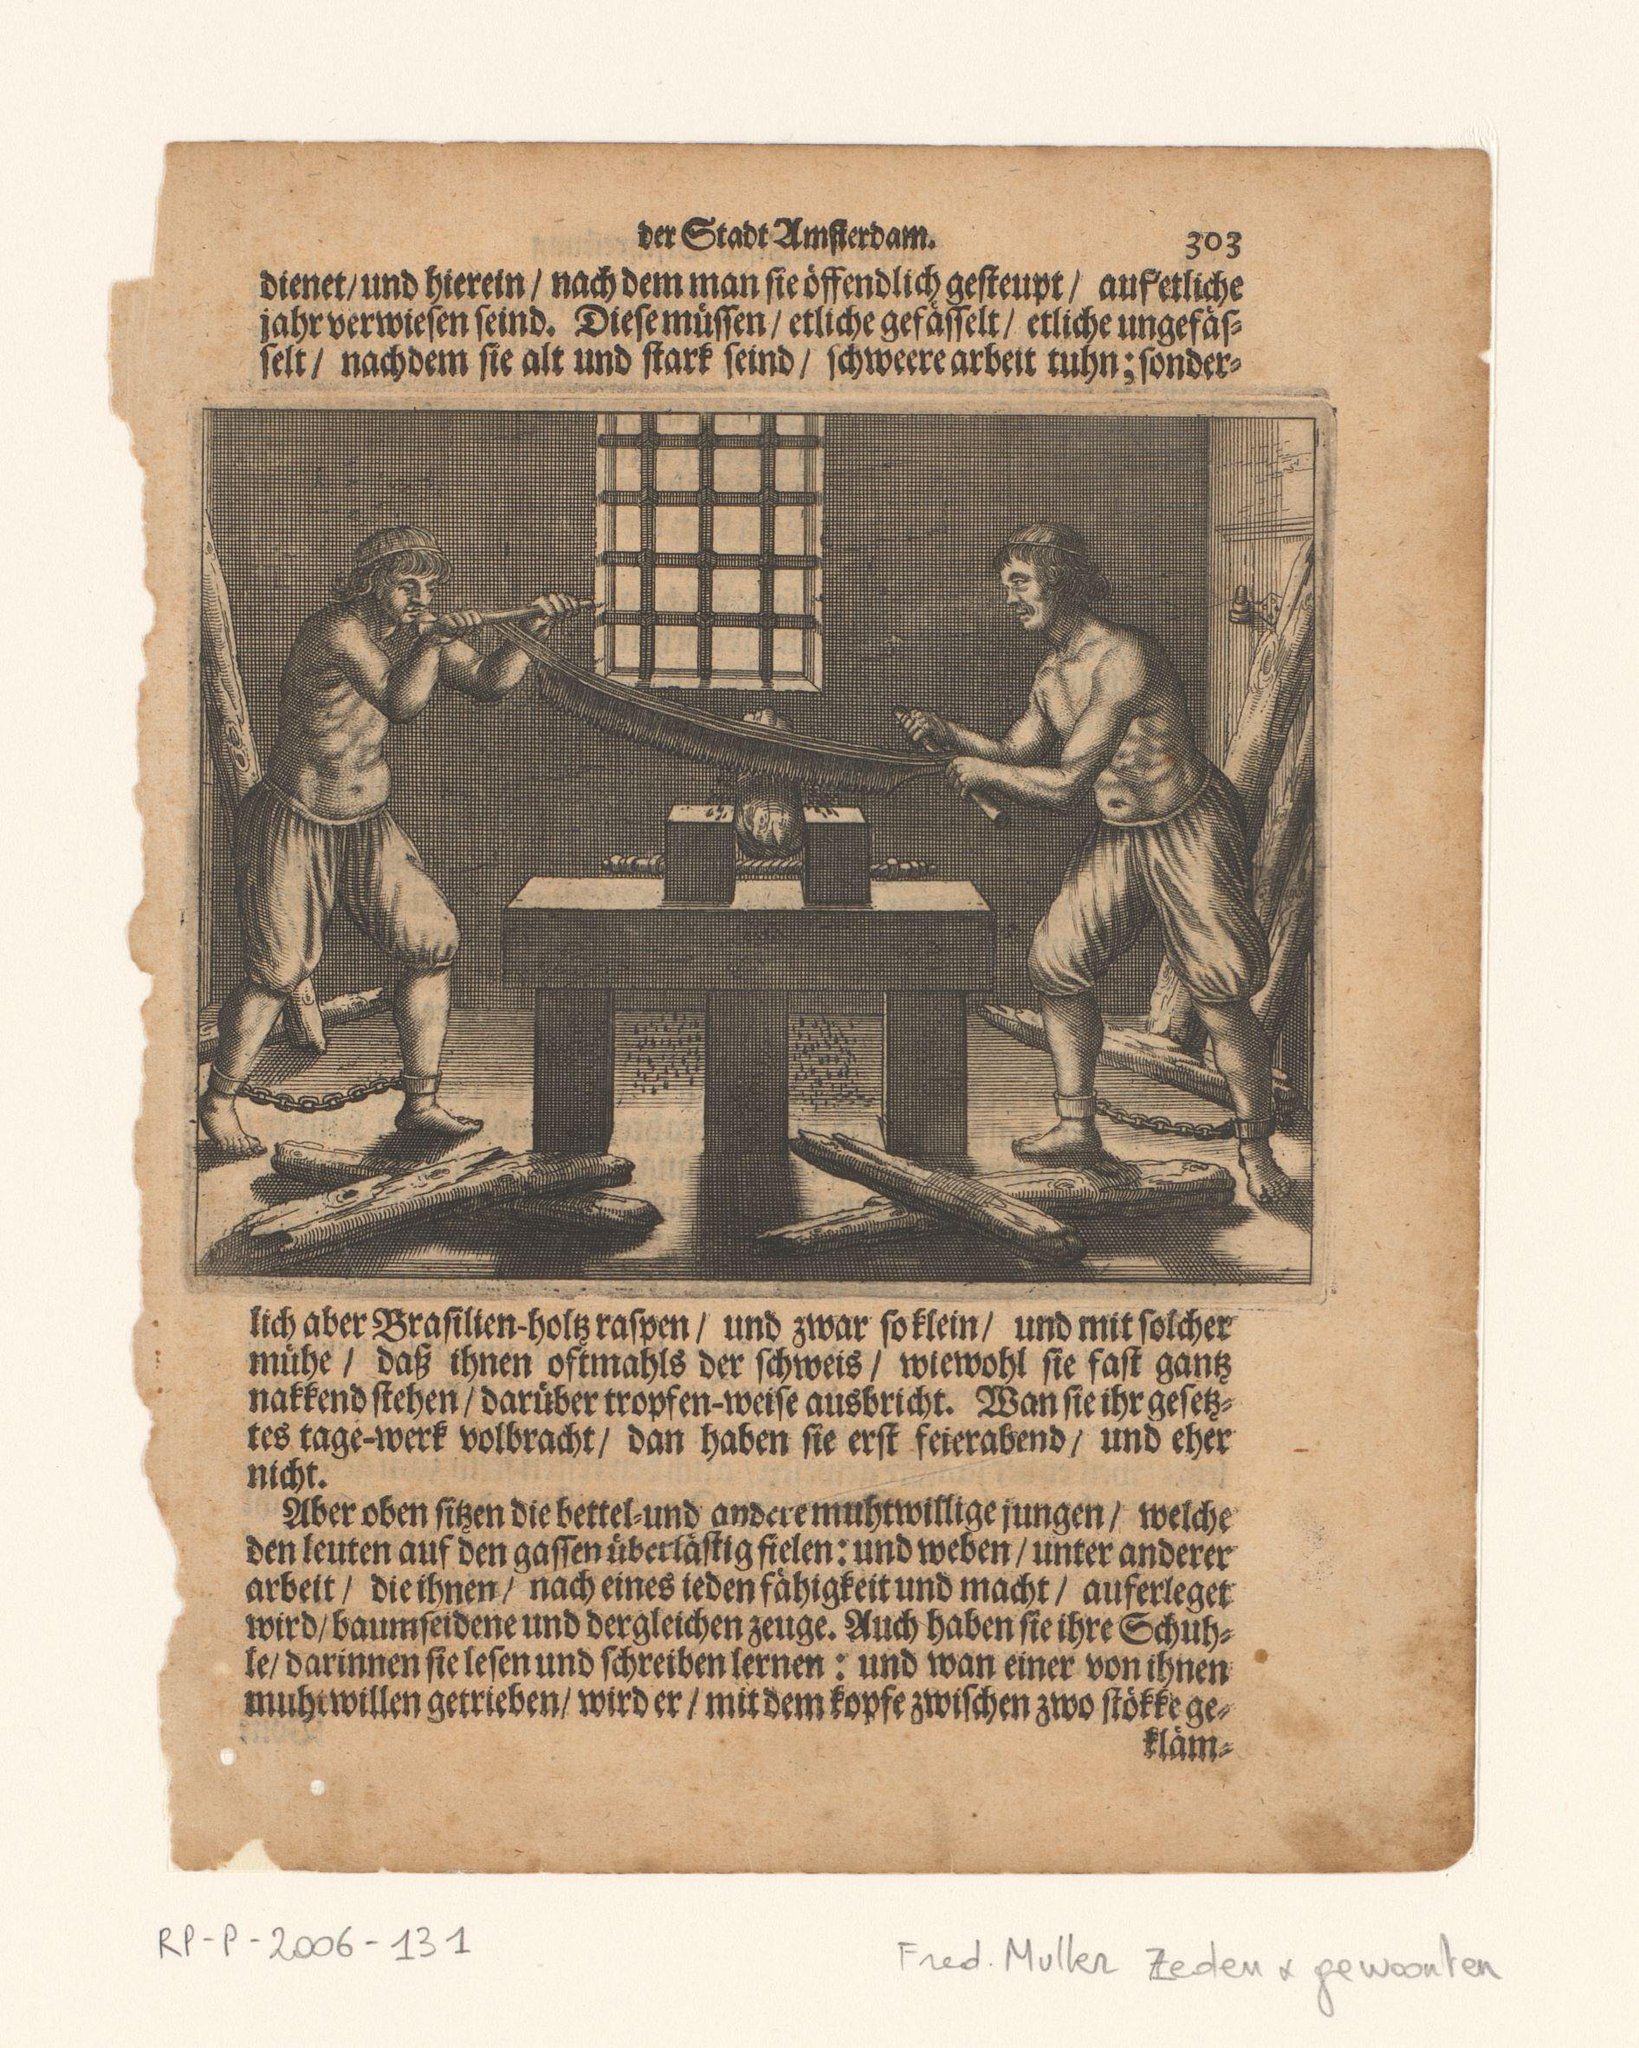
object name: book illustration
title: Twee gevangenen aan het werk in het rasphuis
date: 1664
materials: paper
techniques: etching, letterpress printing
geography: amsterdam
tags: prison, jail, industries ~ wood, prisoner; in fetters, sawing (industrial process)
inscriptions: collector's mark: Lugt 2228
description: Prent uit: Zesen, Philipp von. Beschreibung der Stadt Amsterdam (...). Amsterdam: Joachim Noschen, 1664, p. 303.